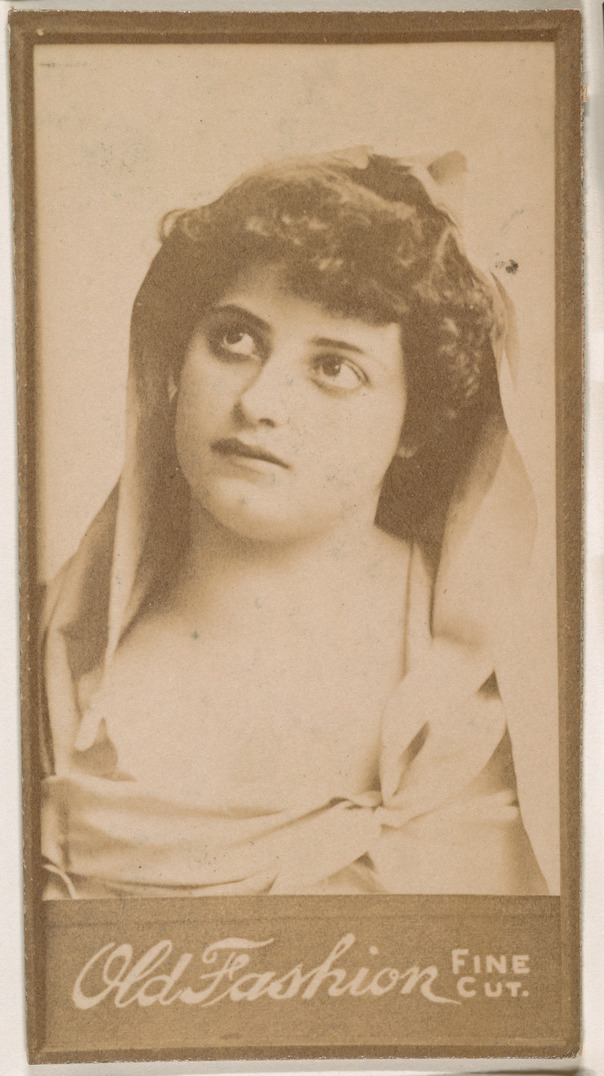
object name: photograph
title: Actress with shawl draped over hair, from the Actresses series (N664) promoting Old Fashion Fine Cut Tobacco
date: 1888-1890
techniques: albumen silver print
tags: portraits,women,actresses